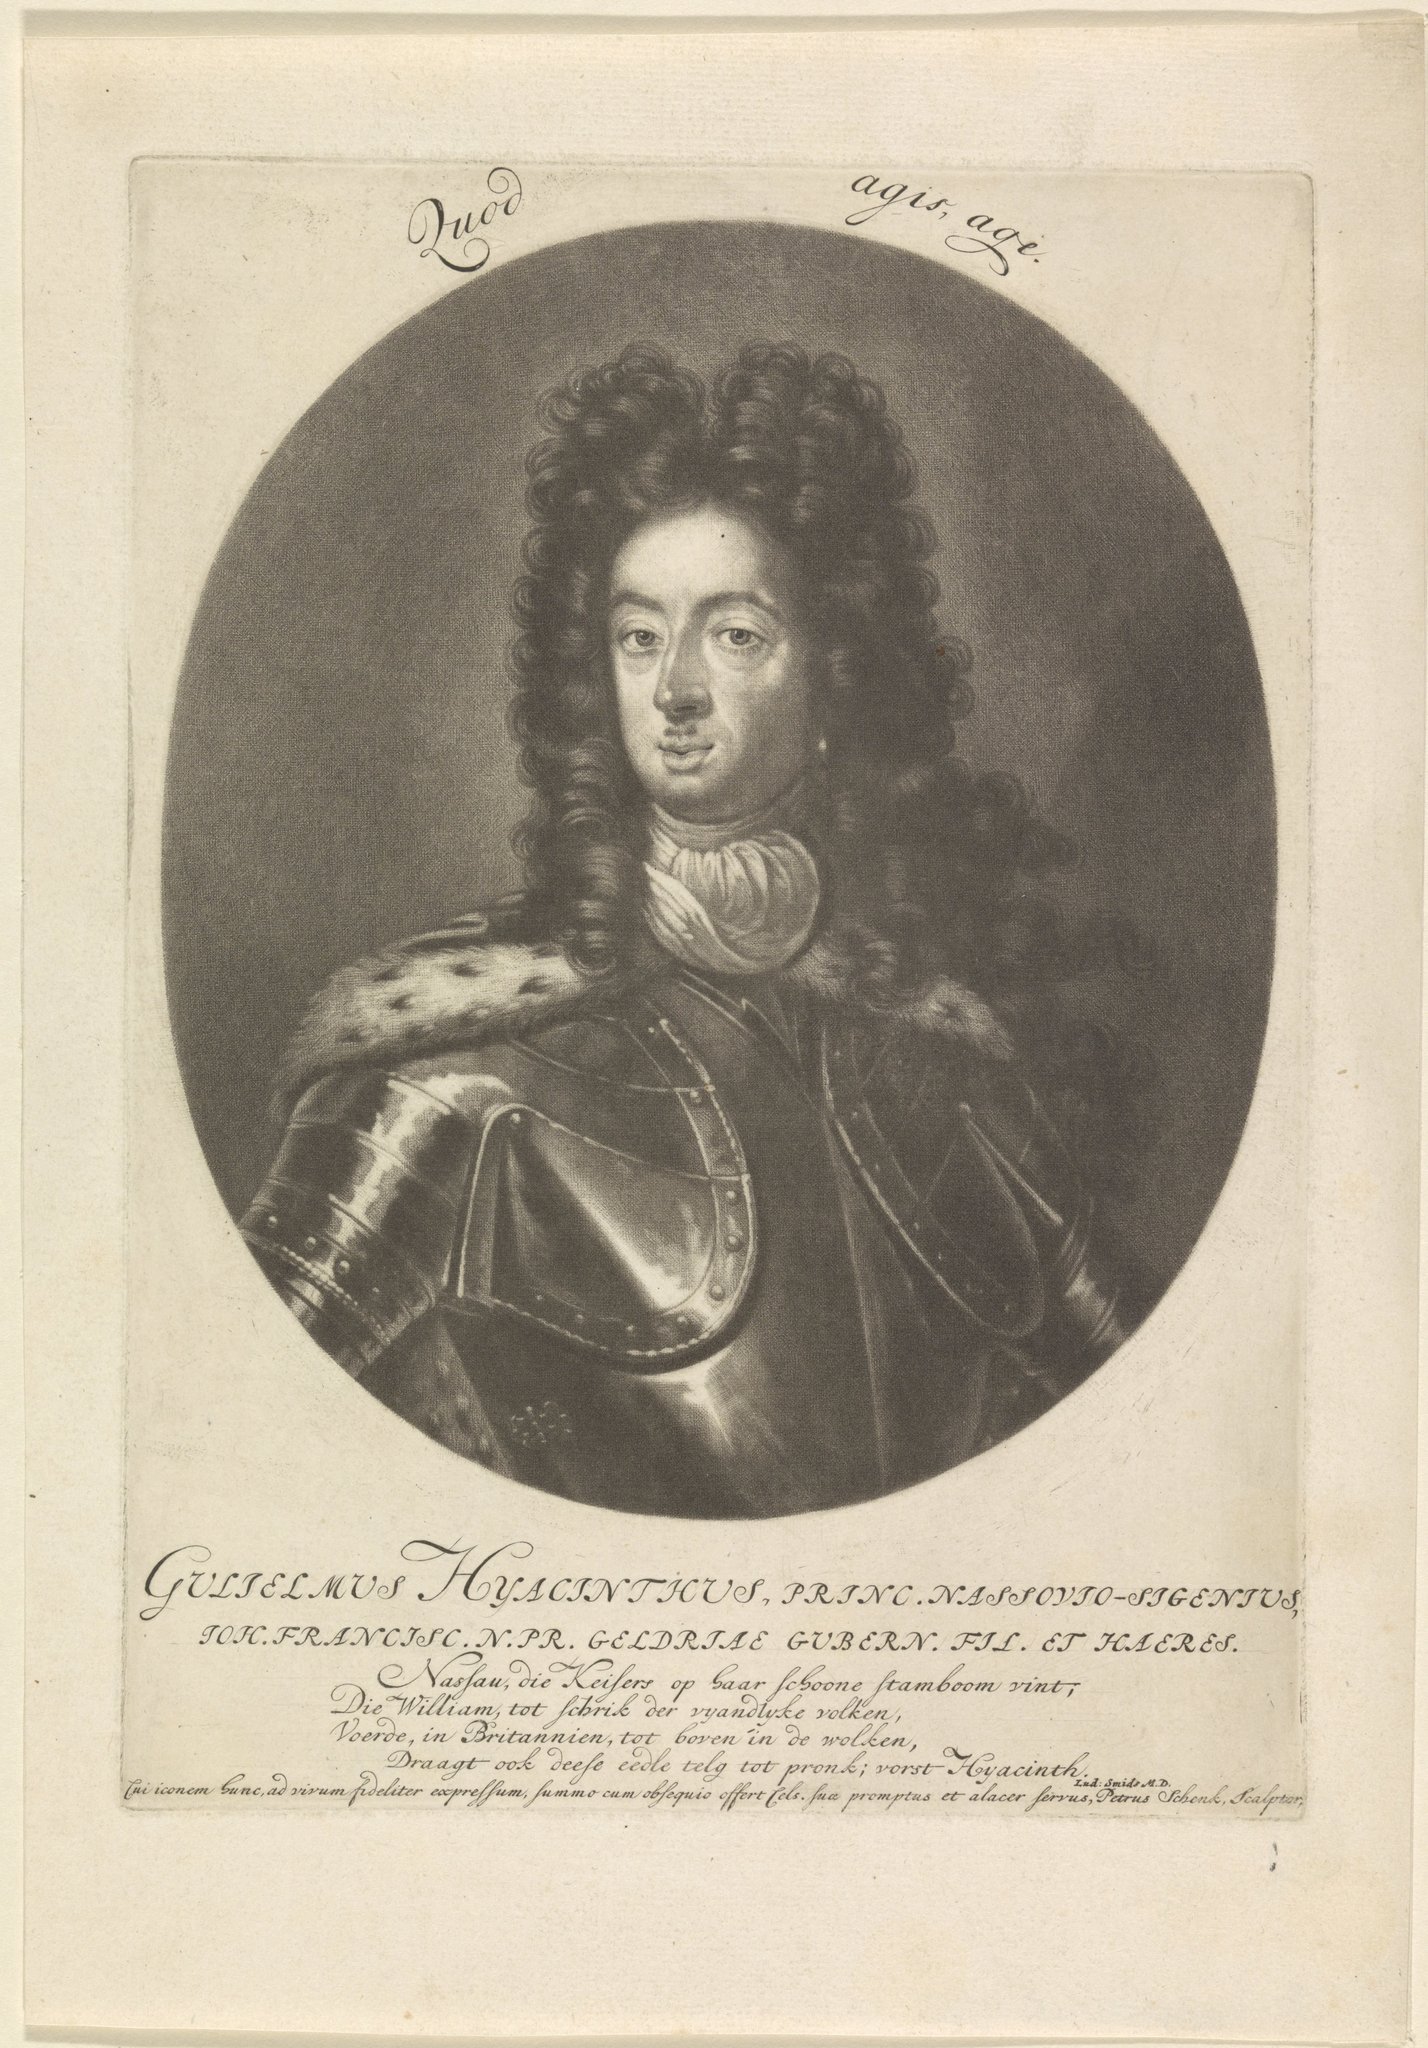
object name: print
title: Portret van Willem Hyacinth, graaf van Nassau-Siegen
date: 1685-1711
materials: paper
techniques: mezzotint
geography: amsterdam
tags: brussels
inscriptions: collector's mark: Lugt 963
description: De hier vermelde titel verwijst naar de hoogst verkregen titel van de geportretteerde, niet per se naar de titel die de geportretteerde op deze voorstelling draagt.